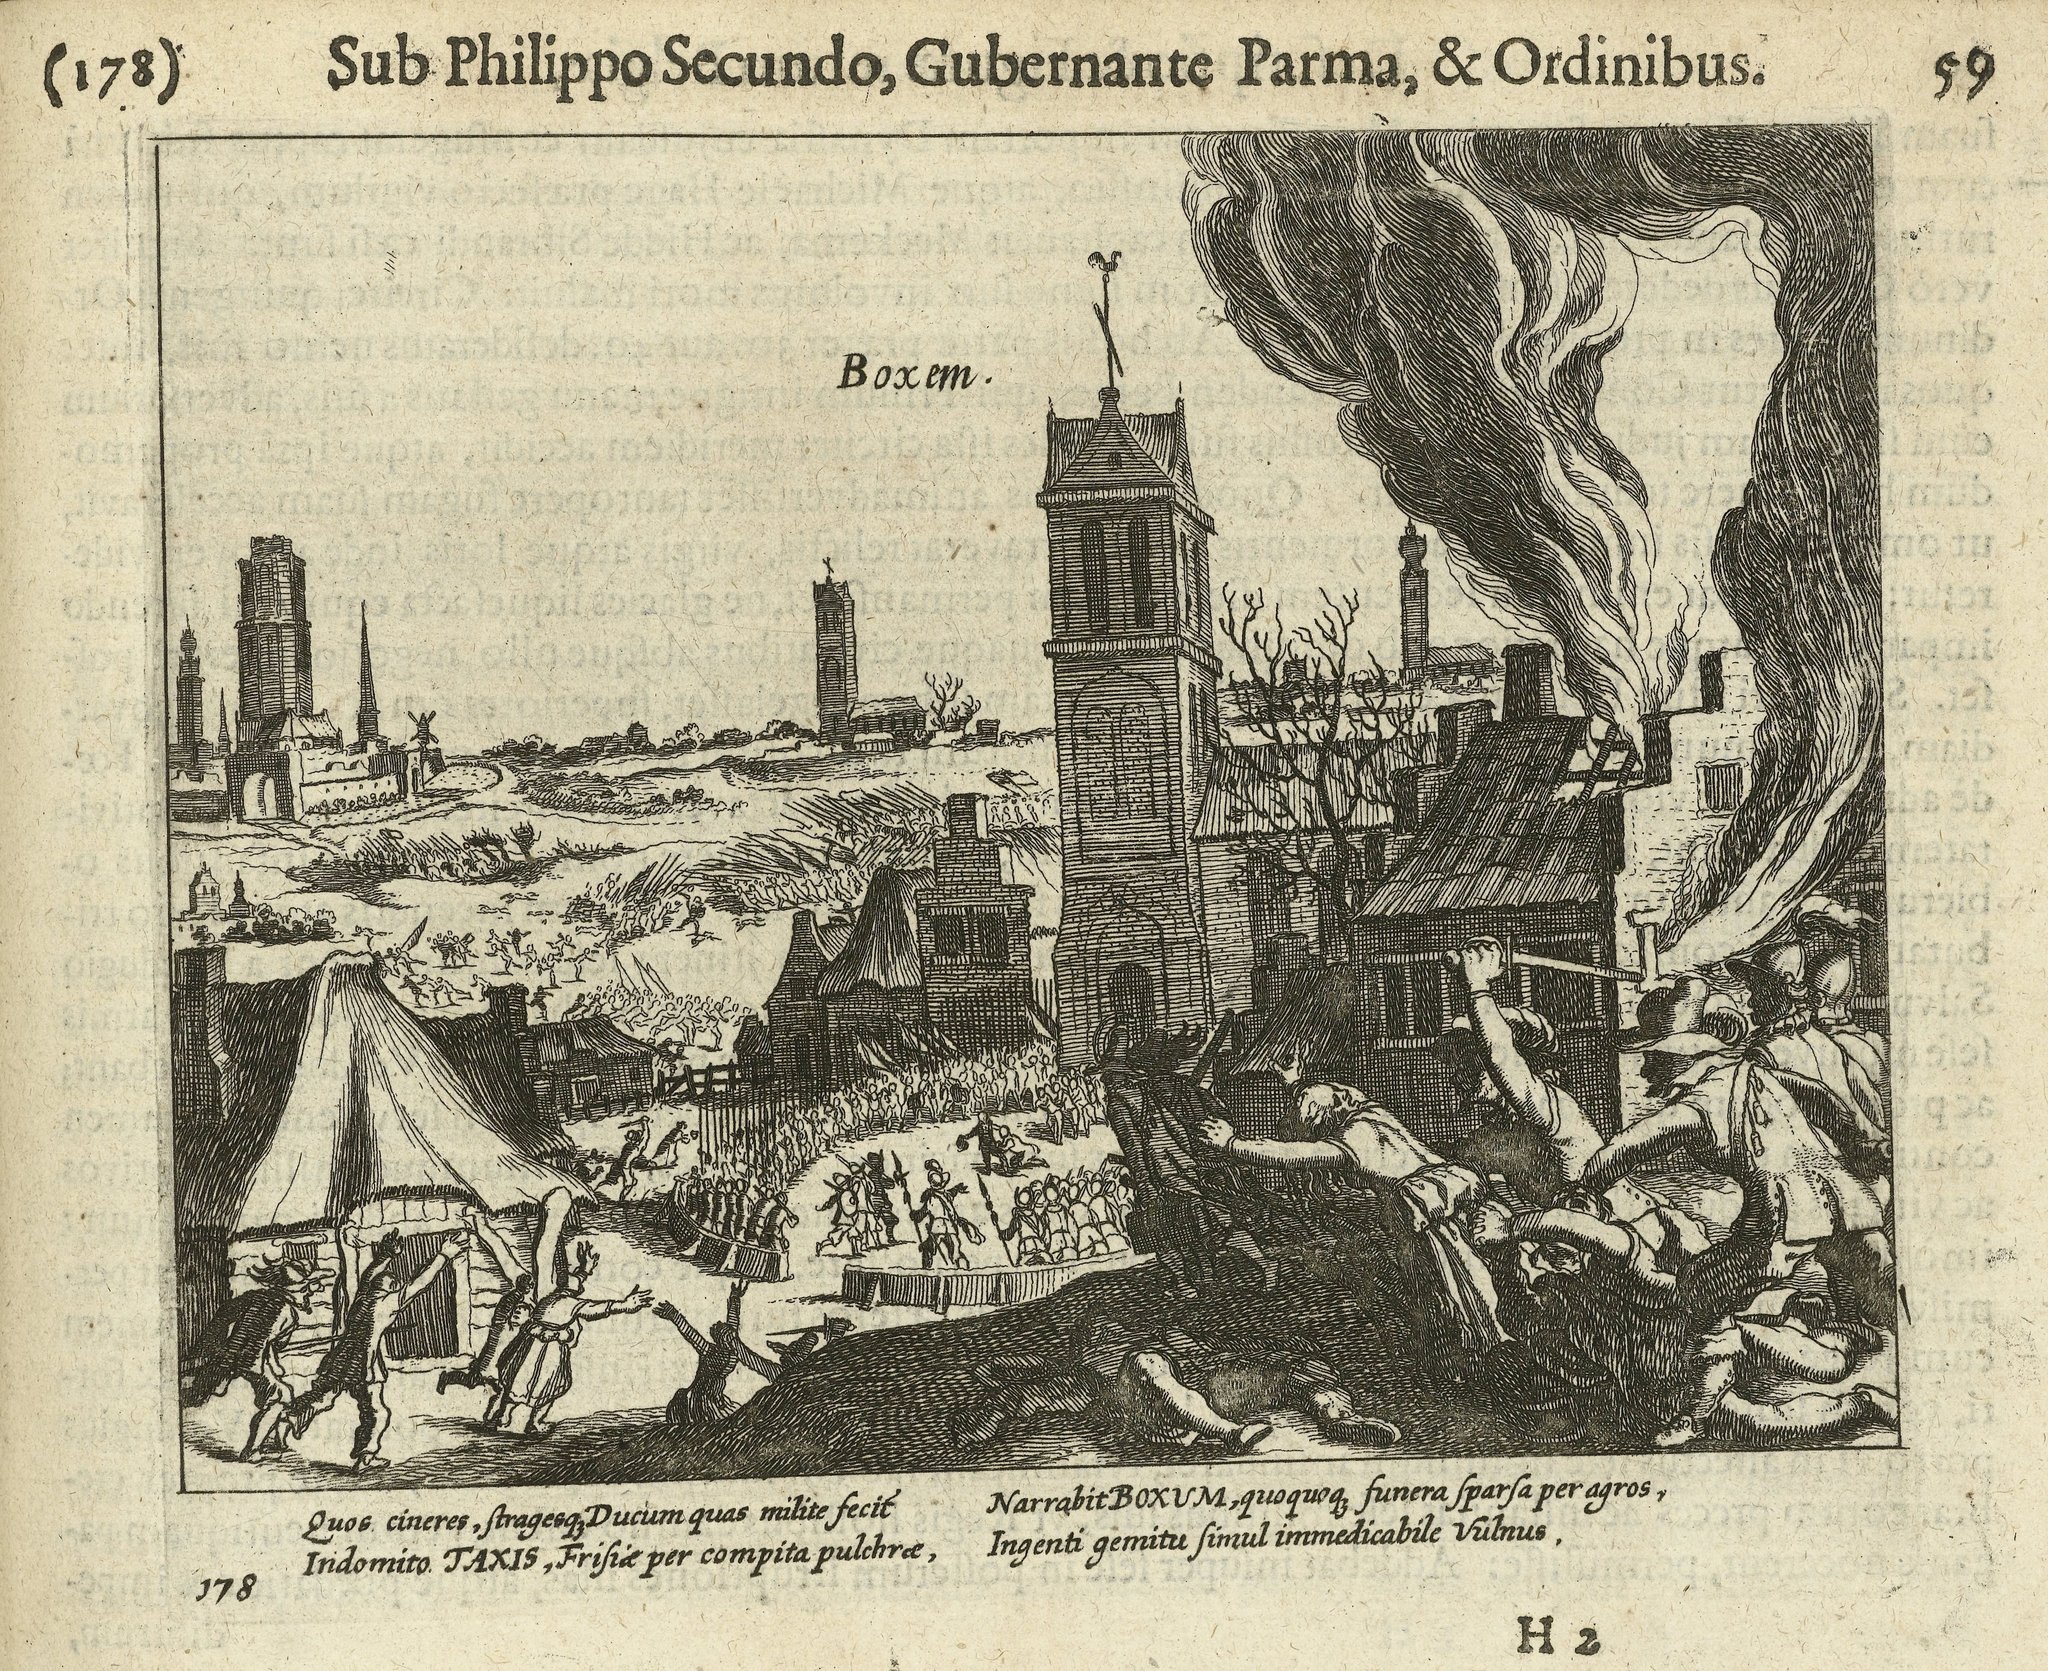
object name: history print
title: Slag bij Boksum in Friesland, 1586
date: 1613-1615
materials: paper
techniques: etching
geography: northern netherlands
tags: battle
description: Slag bij Boksum in Friesland, 26-27 januari 1586. Het Staatse leger door de Spanjaarden verslagen. Gevechten in het open veld en soldaten bij de kerk in Boksum, in de verte Leeuwarden, Winsum en Wielsryp. Met onderschrift van 4 regels in het Latijn. Genummerd: 178. Bedrukt op achterzijde met tekst in het Latijn.